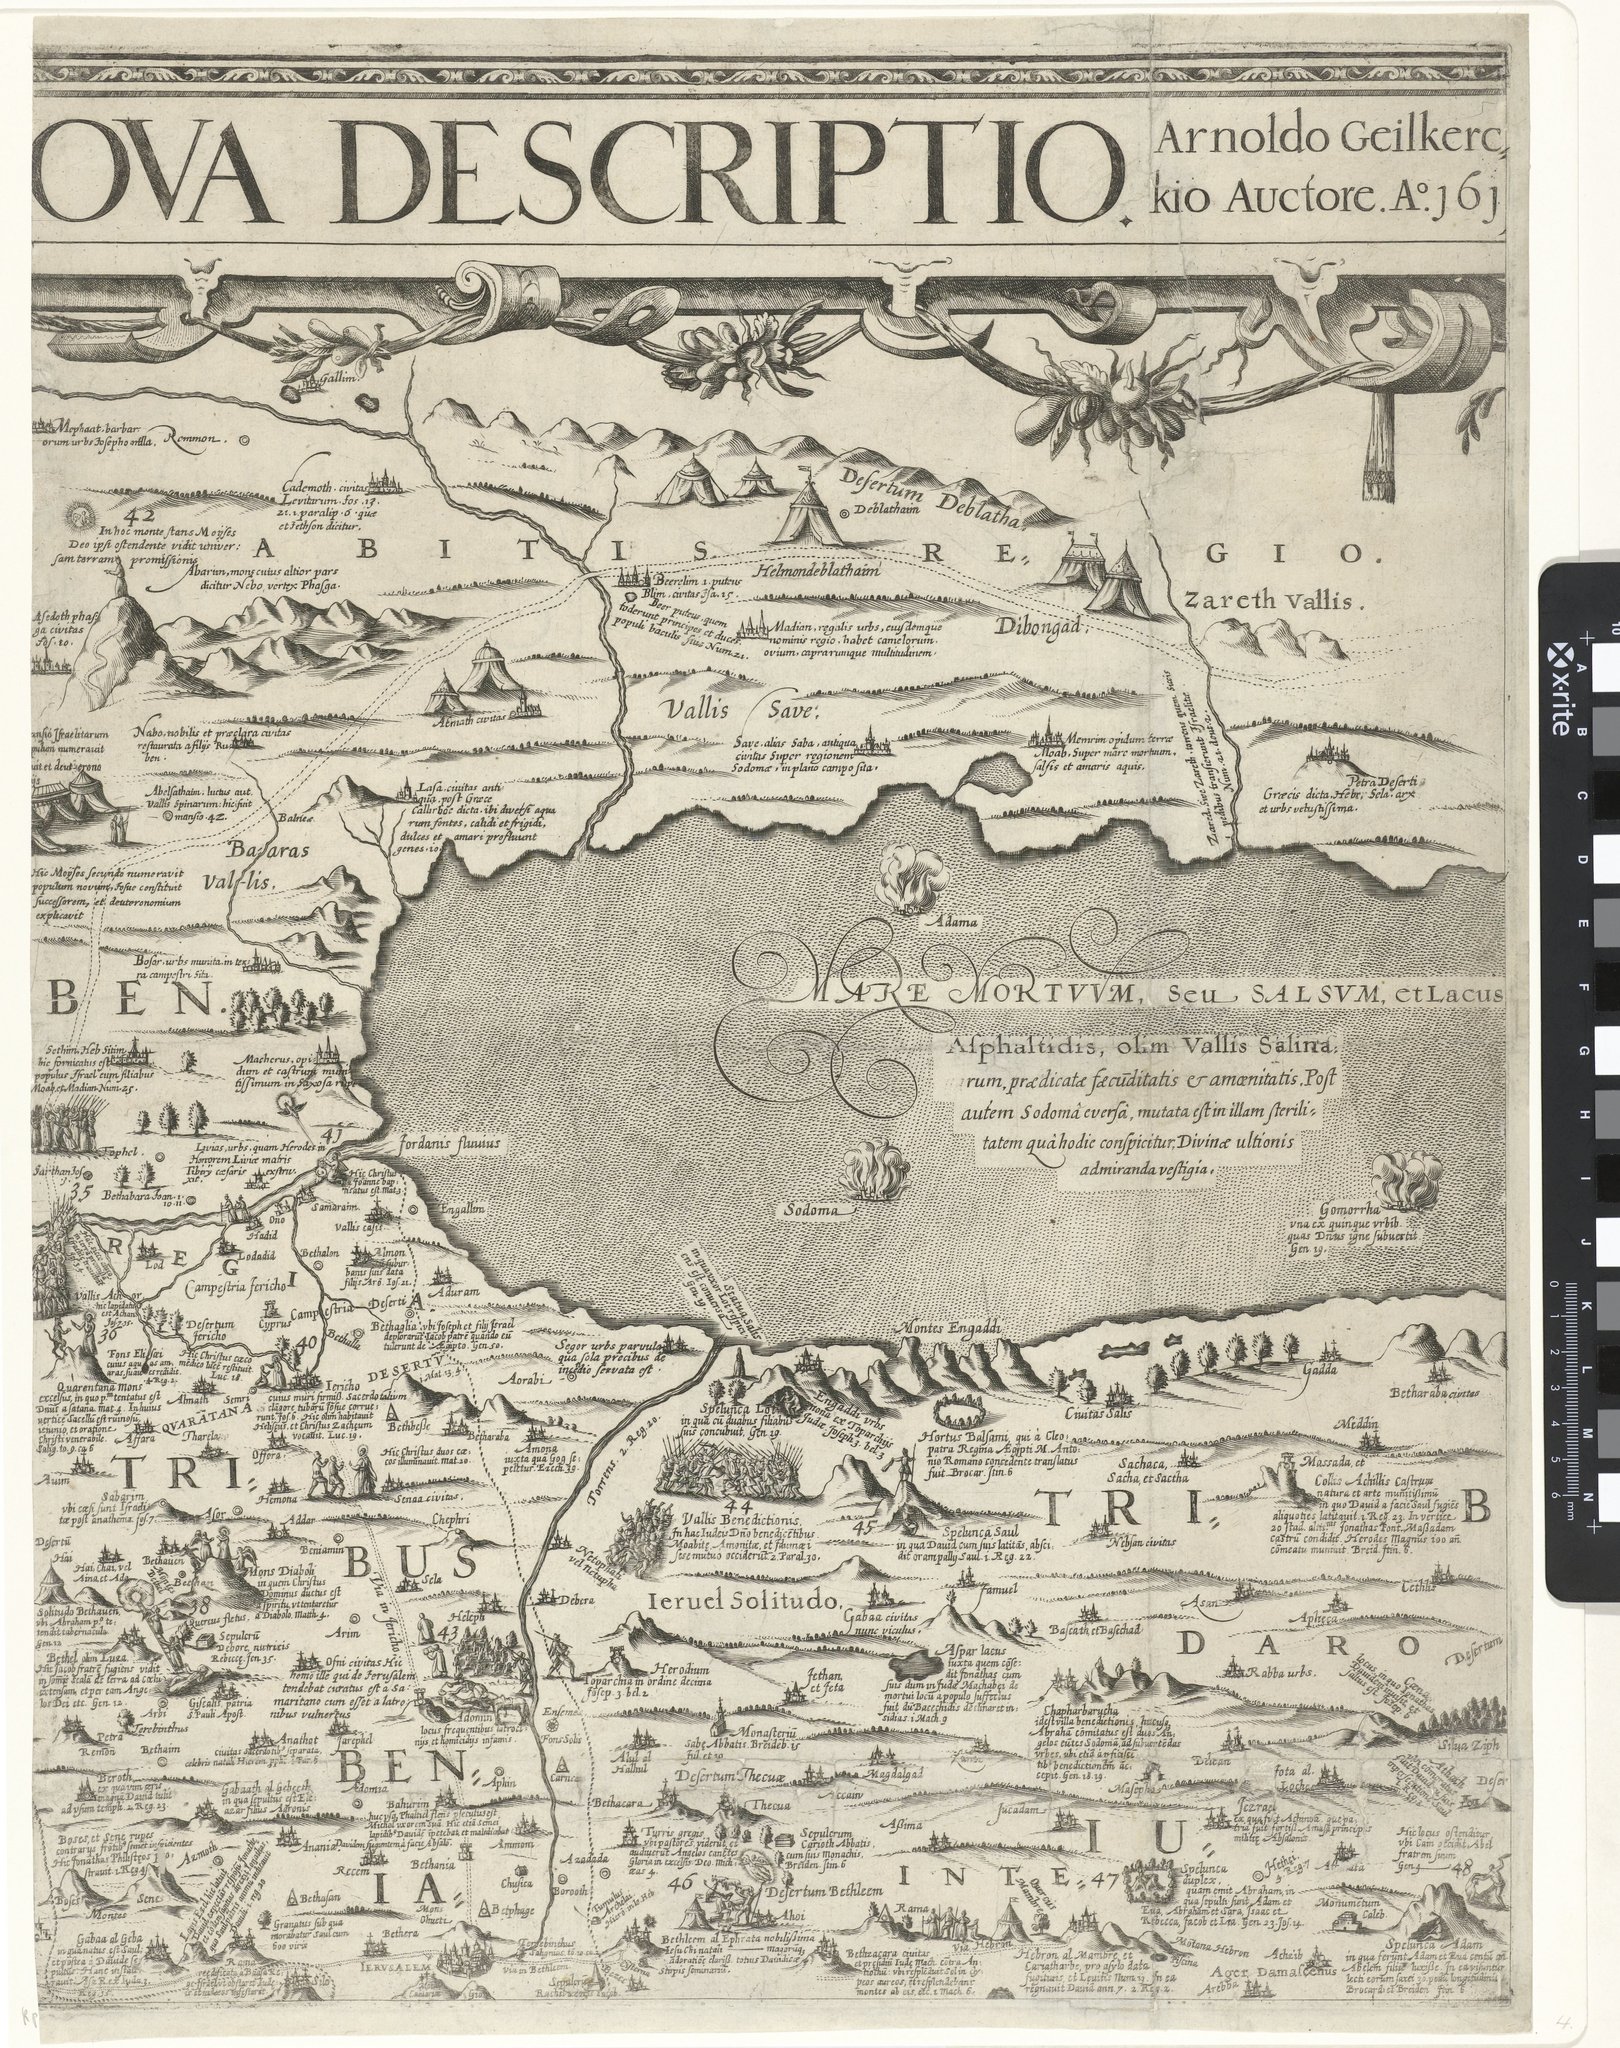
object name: print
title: Terrae Sanctae seu terrae promissionis nova descripto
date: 1621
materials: paper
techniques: engraving, etching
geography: amsterdam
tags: maps, atlases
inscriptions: collector's mark: Lugt 2228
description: Rechtermiddenbovenplaat van een kaart van Palestina, met opschriften die betrekking hebben op de gebeurtenissen van het Oude en Nieuwe Testament.